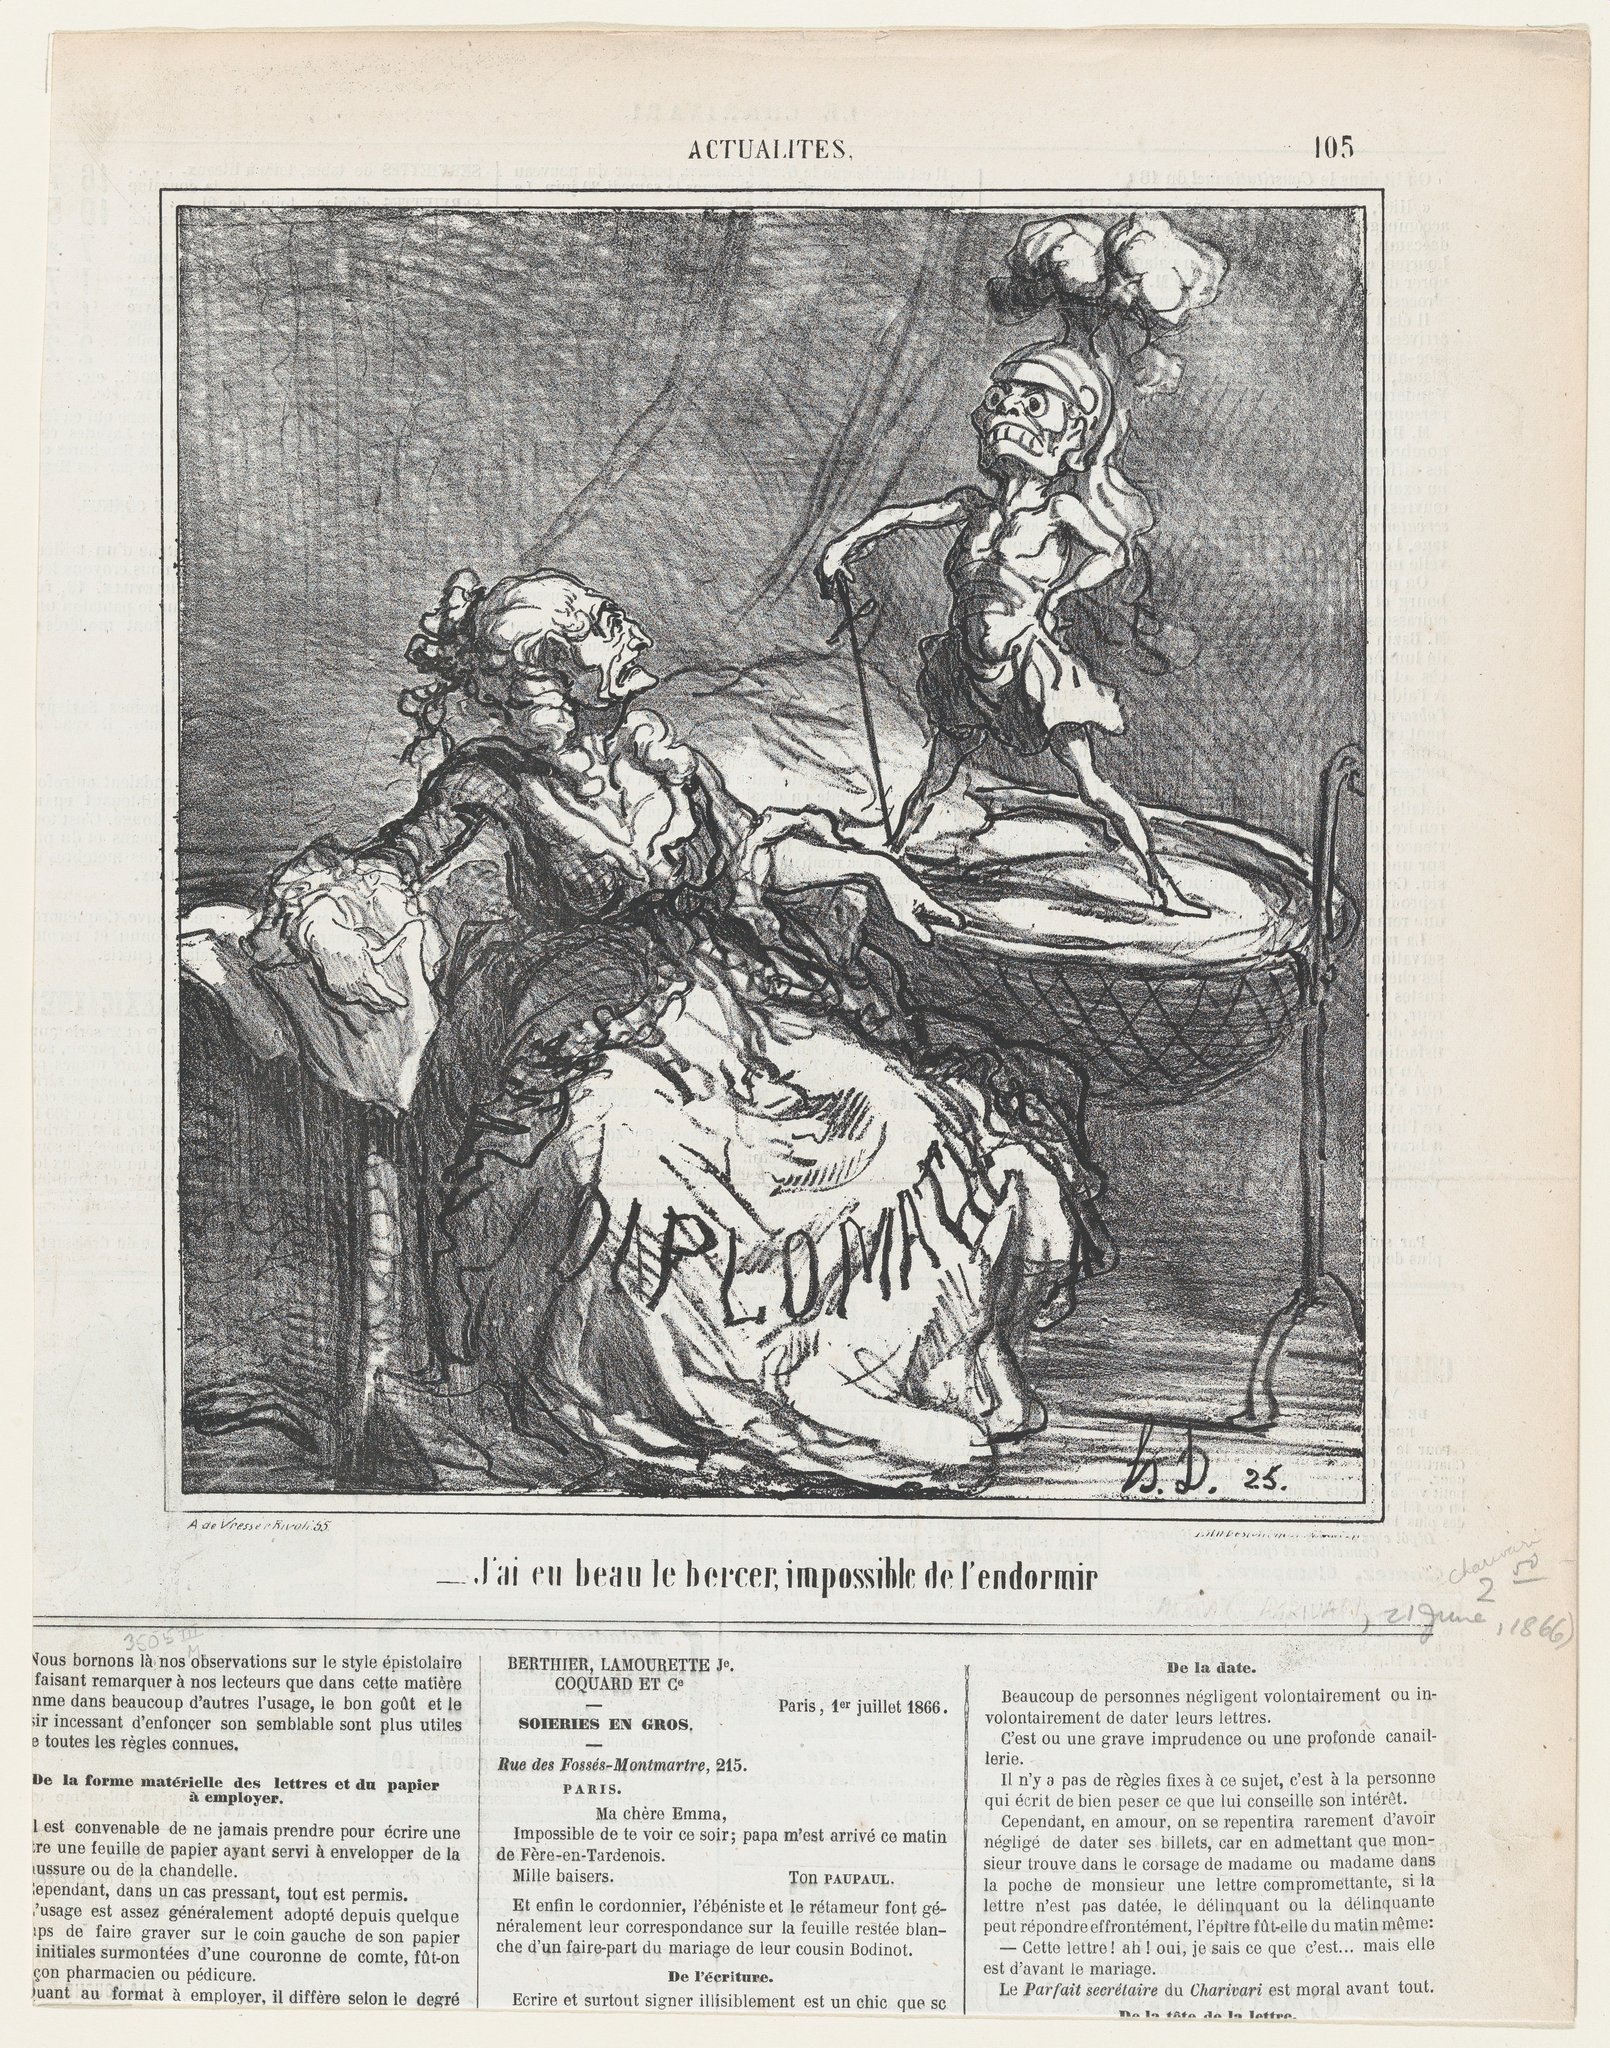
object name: print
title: No matter how much I rock him, it is impossible to make him fall asleep, from 'News of the day,' published in Le Charivari, June 21, 1866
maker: honoré daumier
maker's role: artist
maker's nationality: french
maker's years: 1808-1879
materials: paper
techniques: lithograph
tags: satire,men,women